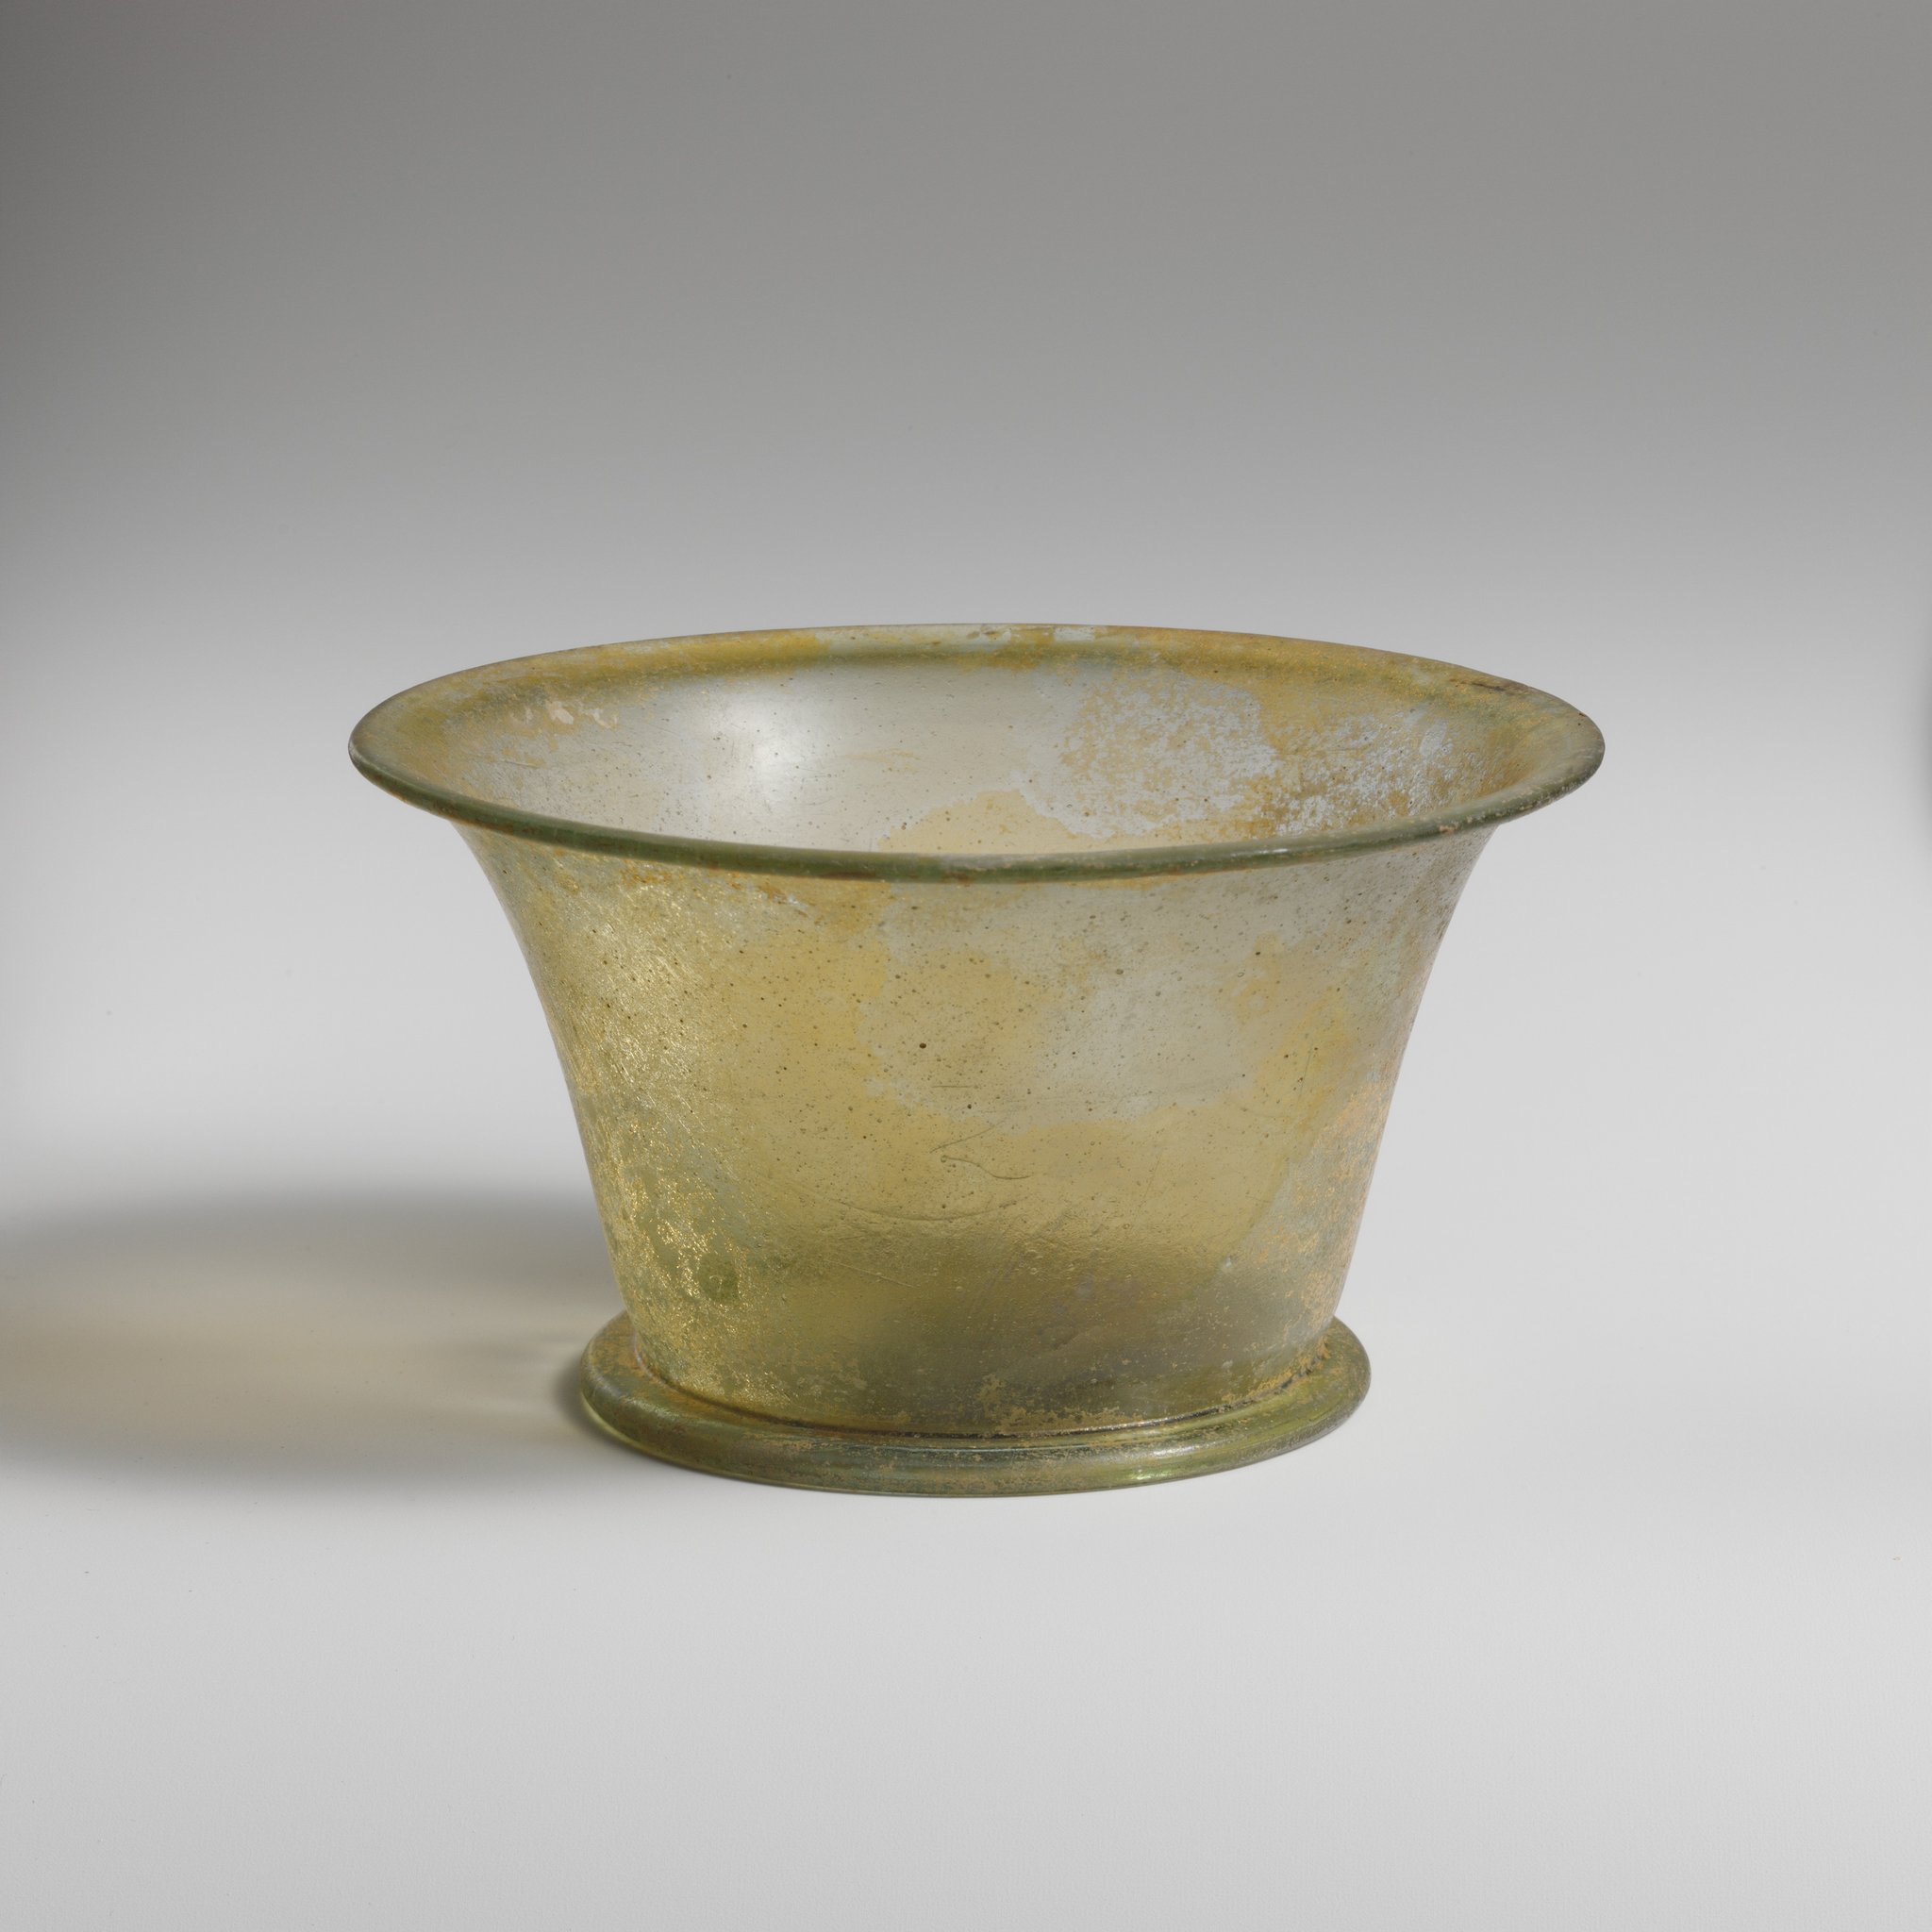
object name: cup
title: Glass cup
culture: roman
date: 1-133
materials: glass